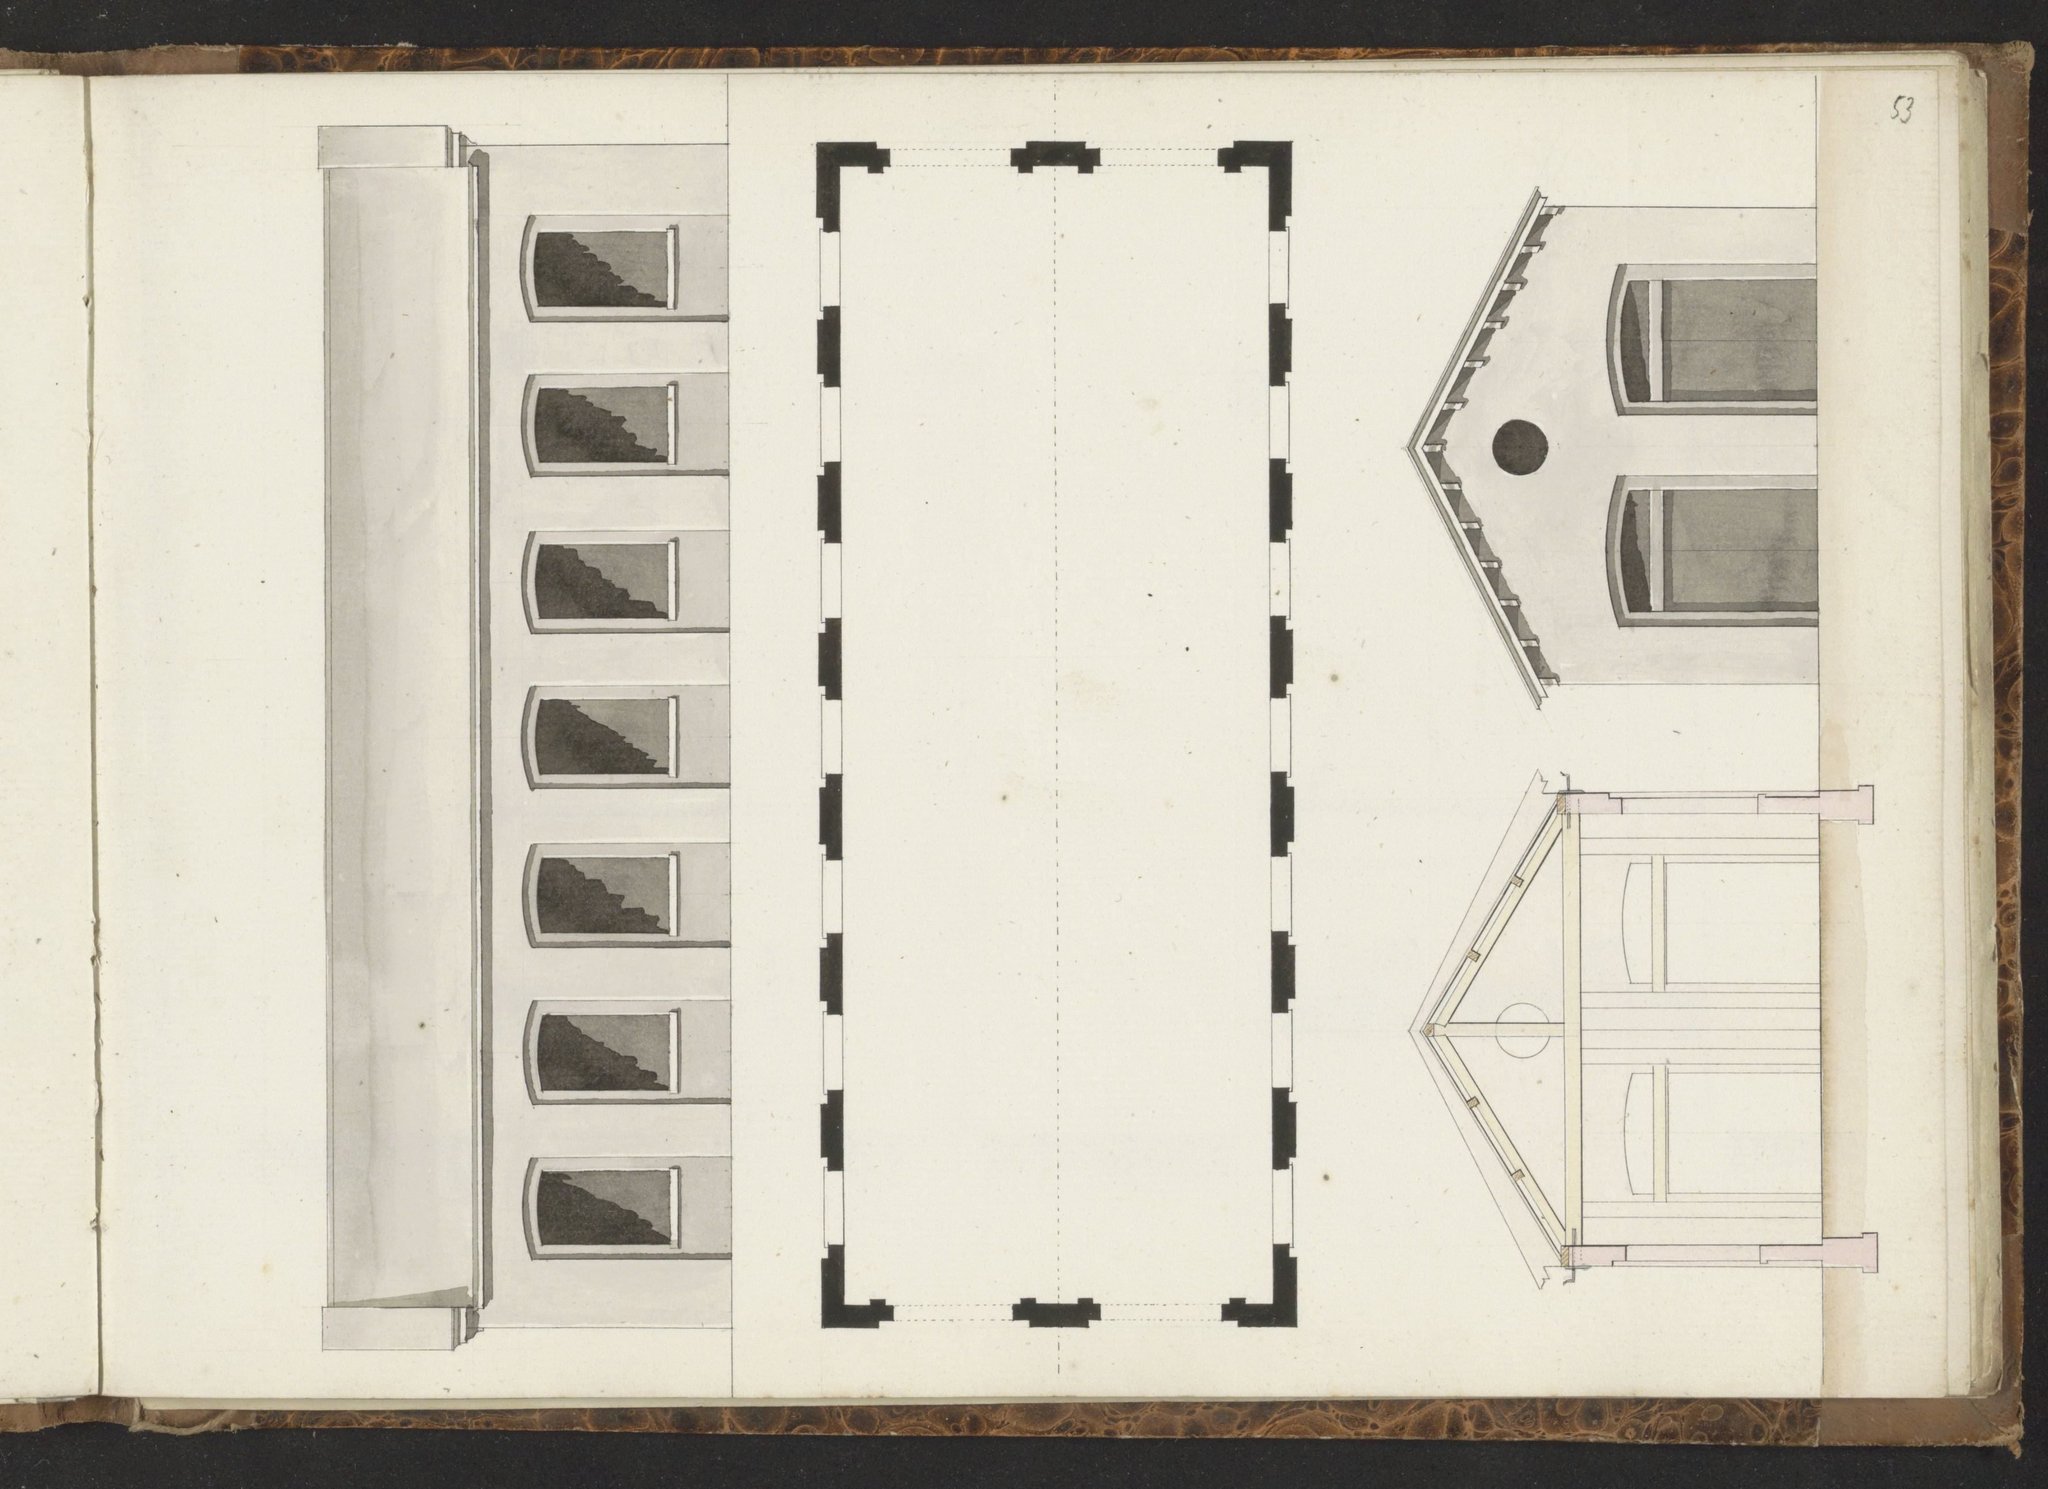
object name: sketchbook leaf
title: Plattegrond, doorsneden en zijgevel van een gebouw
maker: willem springer jr.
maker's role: draughtsman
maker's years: 1815-1907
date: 1825-1907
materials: ink, paper, pencil, watercolor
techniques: brush, pen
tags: façade (of house or building), plan ~ architecture, section ~ architectural design or model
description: Pagina 53 uit een schetsboek met 86 pagina's.